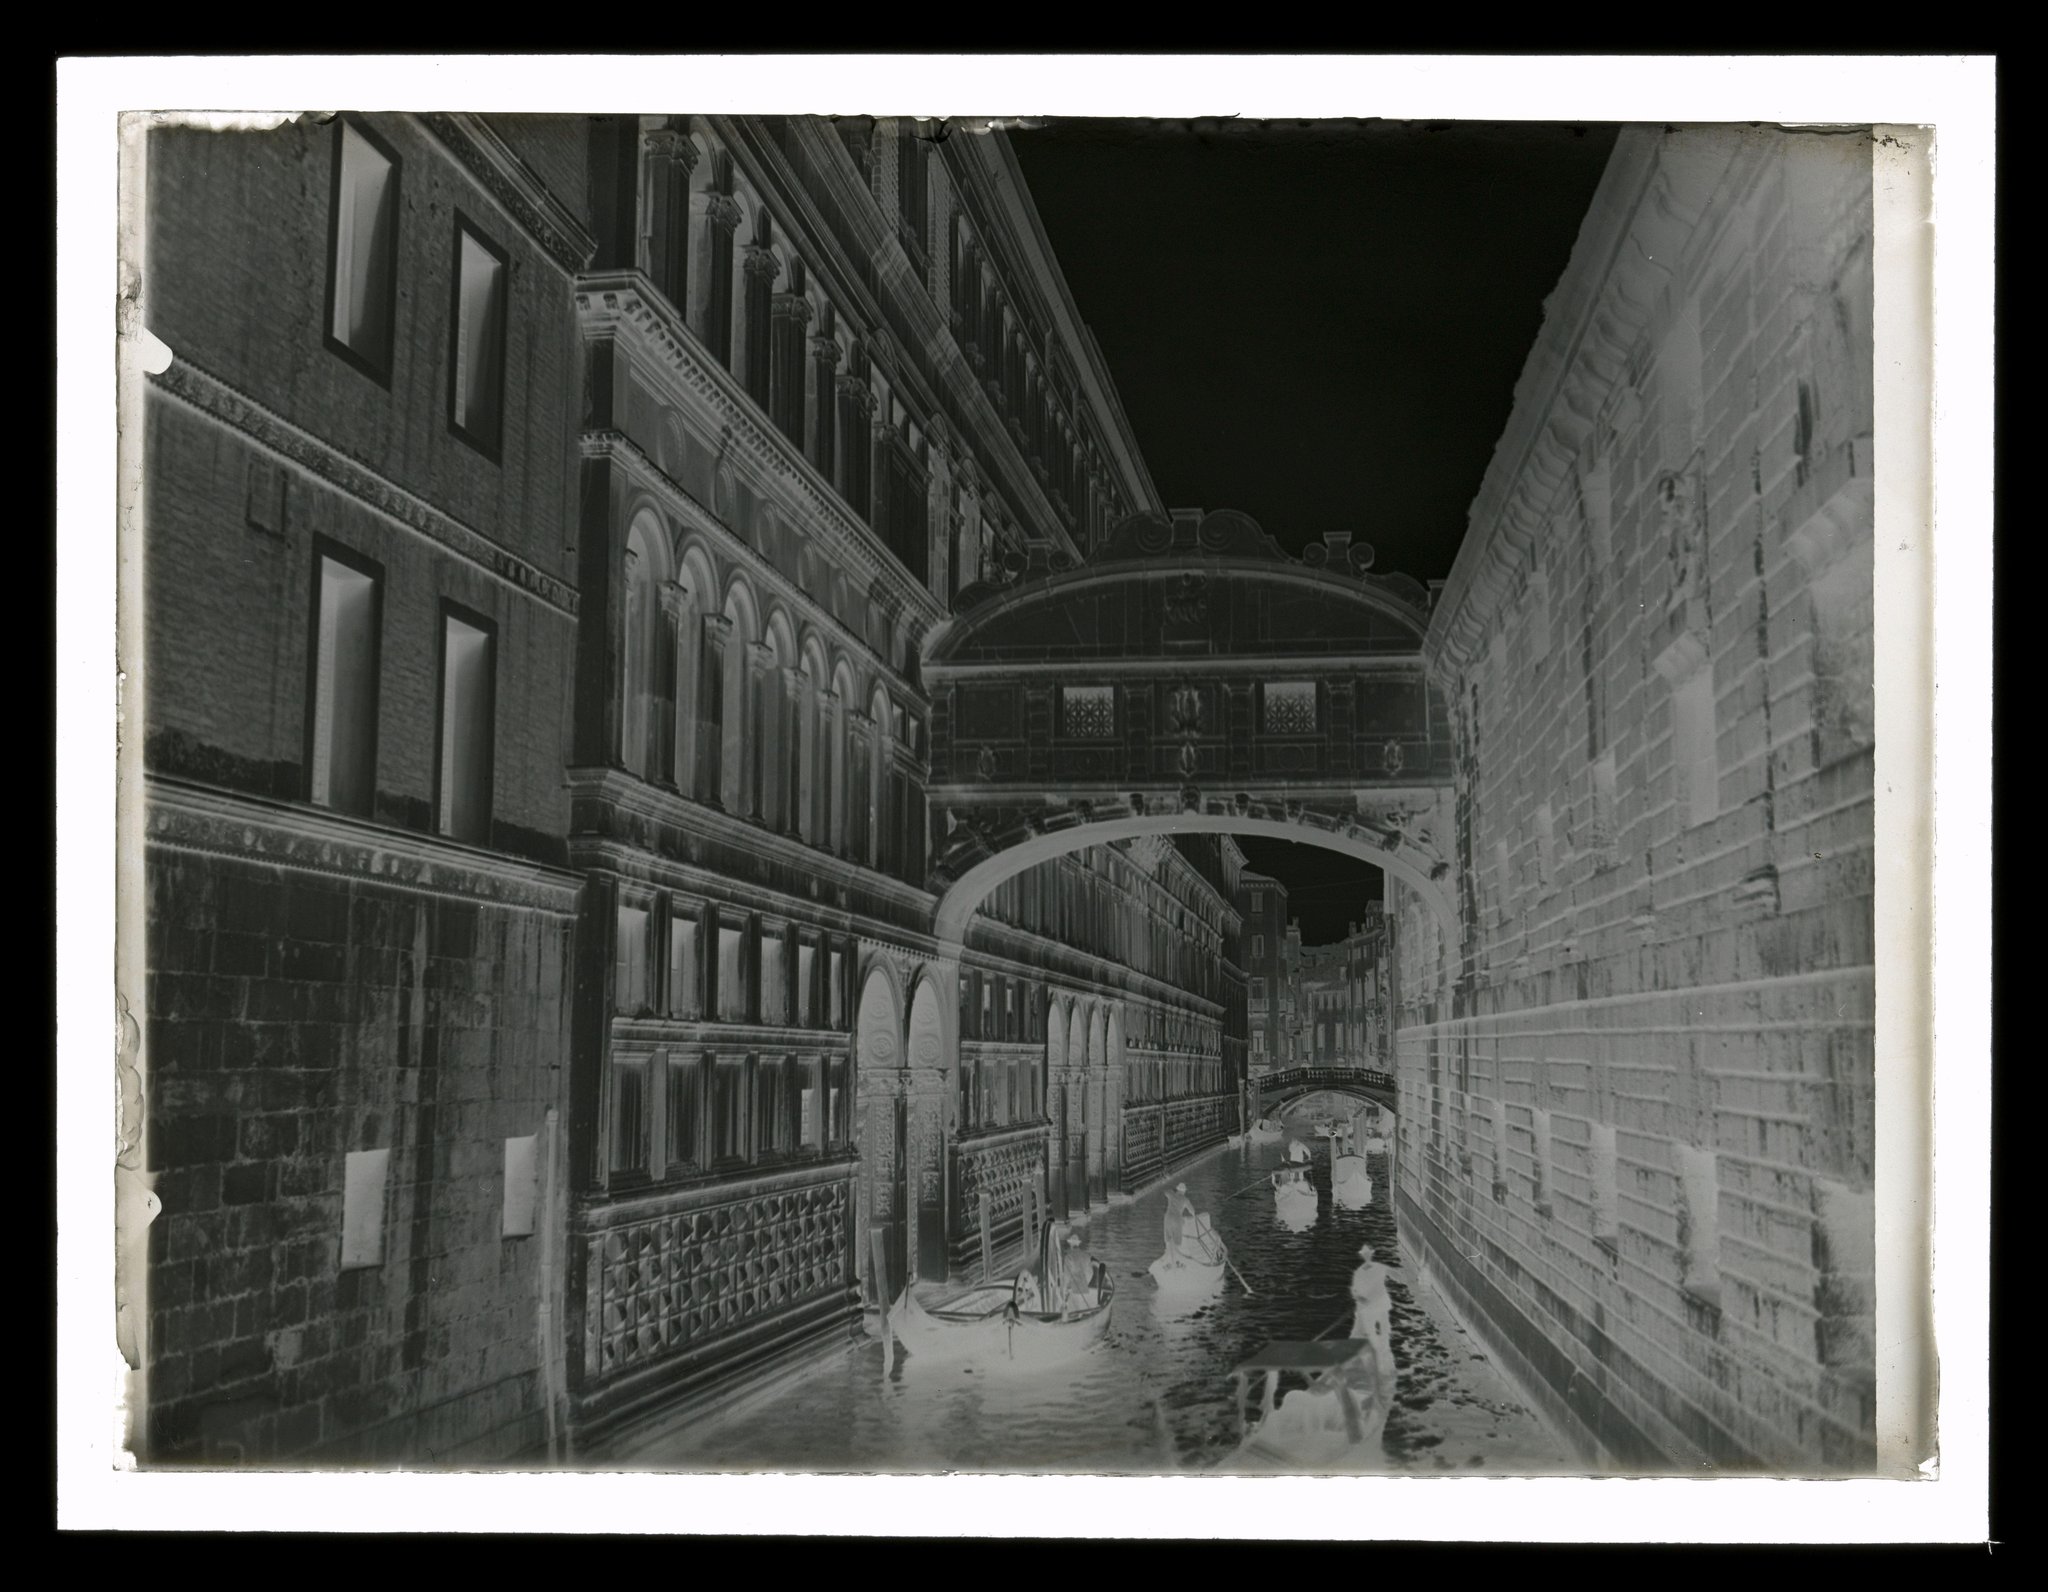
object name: glasnegatief, glasplaatnegatief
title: Gezicht op een kanaal met gondels in Venetië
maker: Anonymous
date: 1907-1935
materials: glass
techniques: gelatin glass negative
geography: venice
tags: canals, waters (in city), gondola, venice